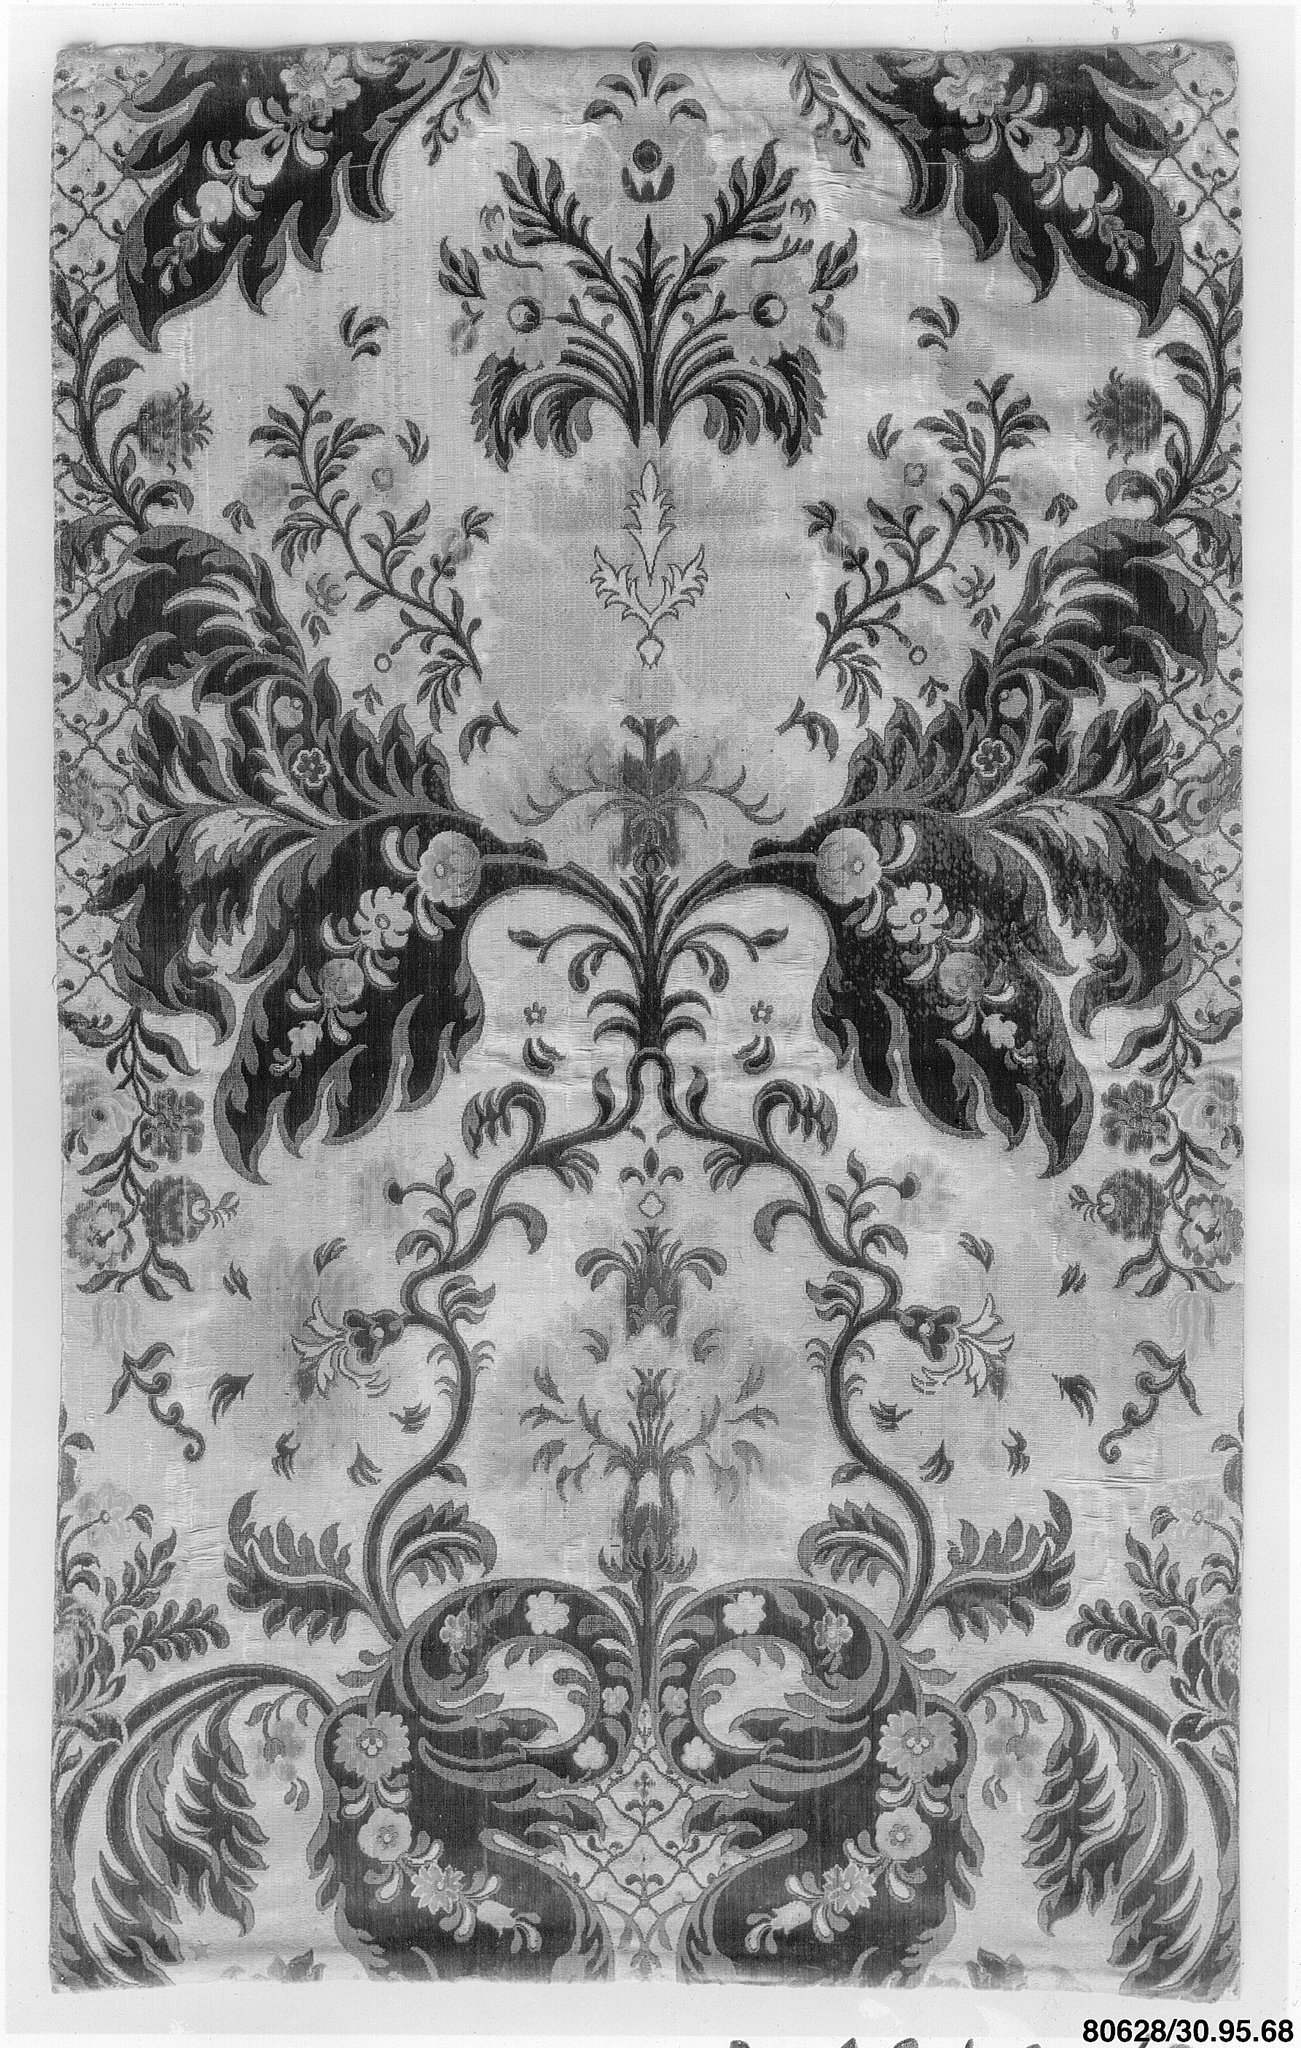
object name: piece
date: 1601-1800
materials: metal thread, silk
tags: flowers,leaves